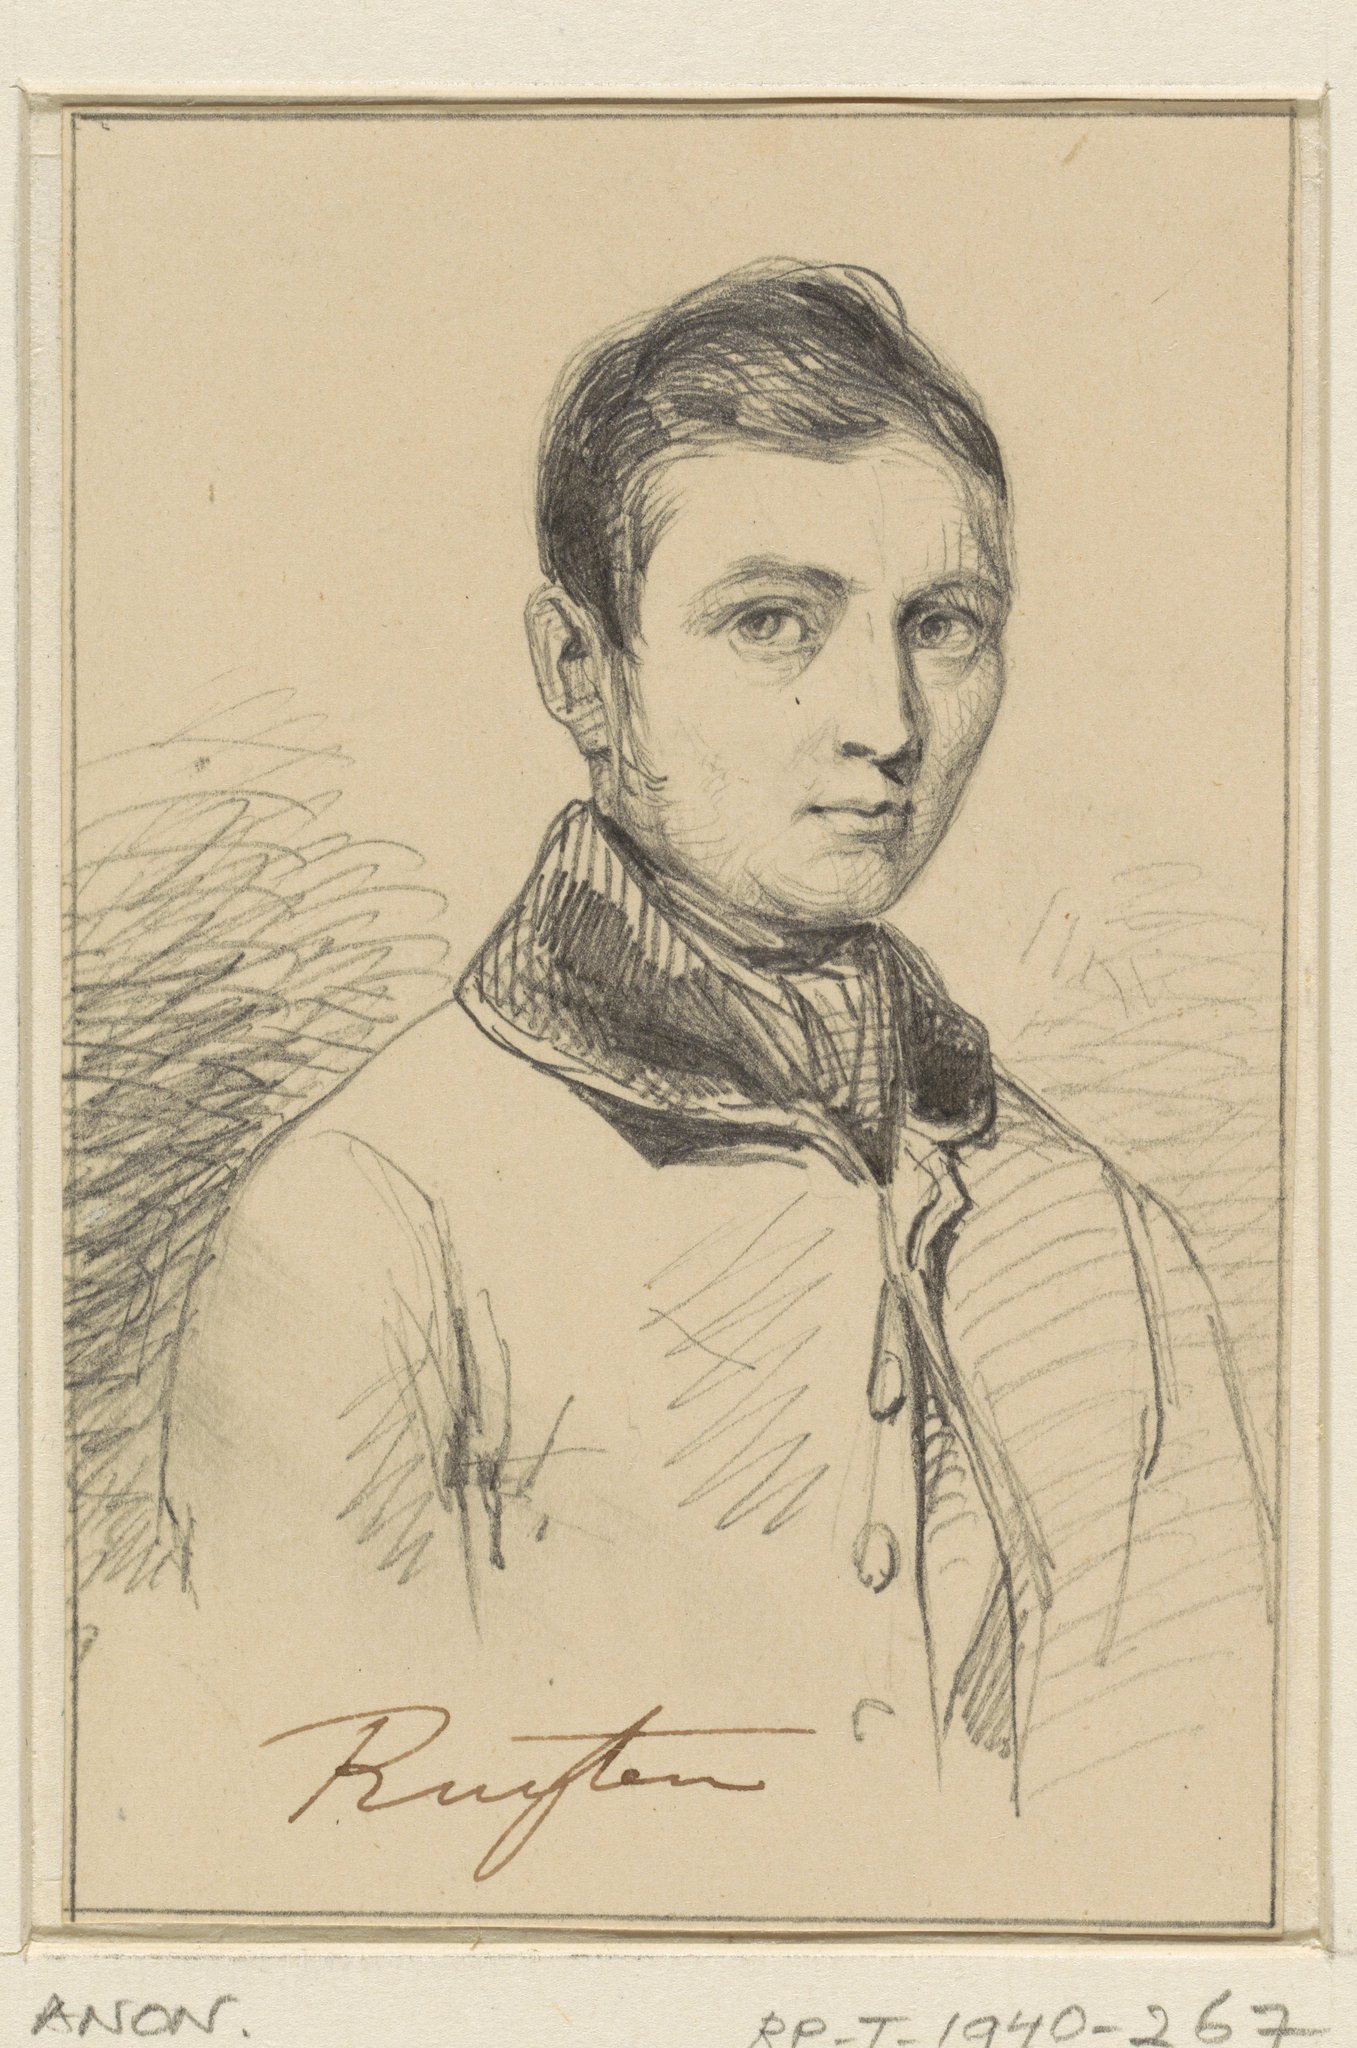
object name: drawing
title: Portret van Jean Michel Ruyten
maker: Anonymous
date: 1800-1900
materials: paper, pencil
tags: antwerp, print maker, draughtsman, jean michel ruyten, historical persons, portrait, self-portrait of artist